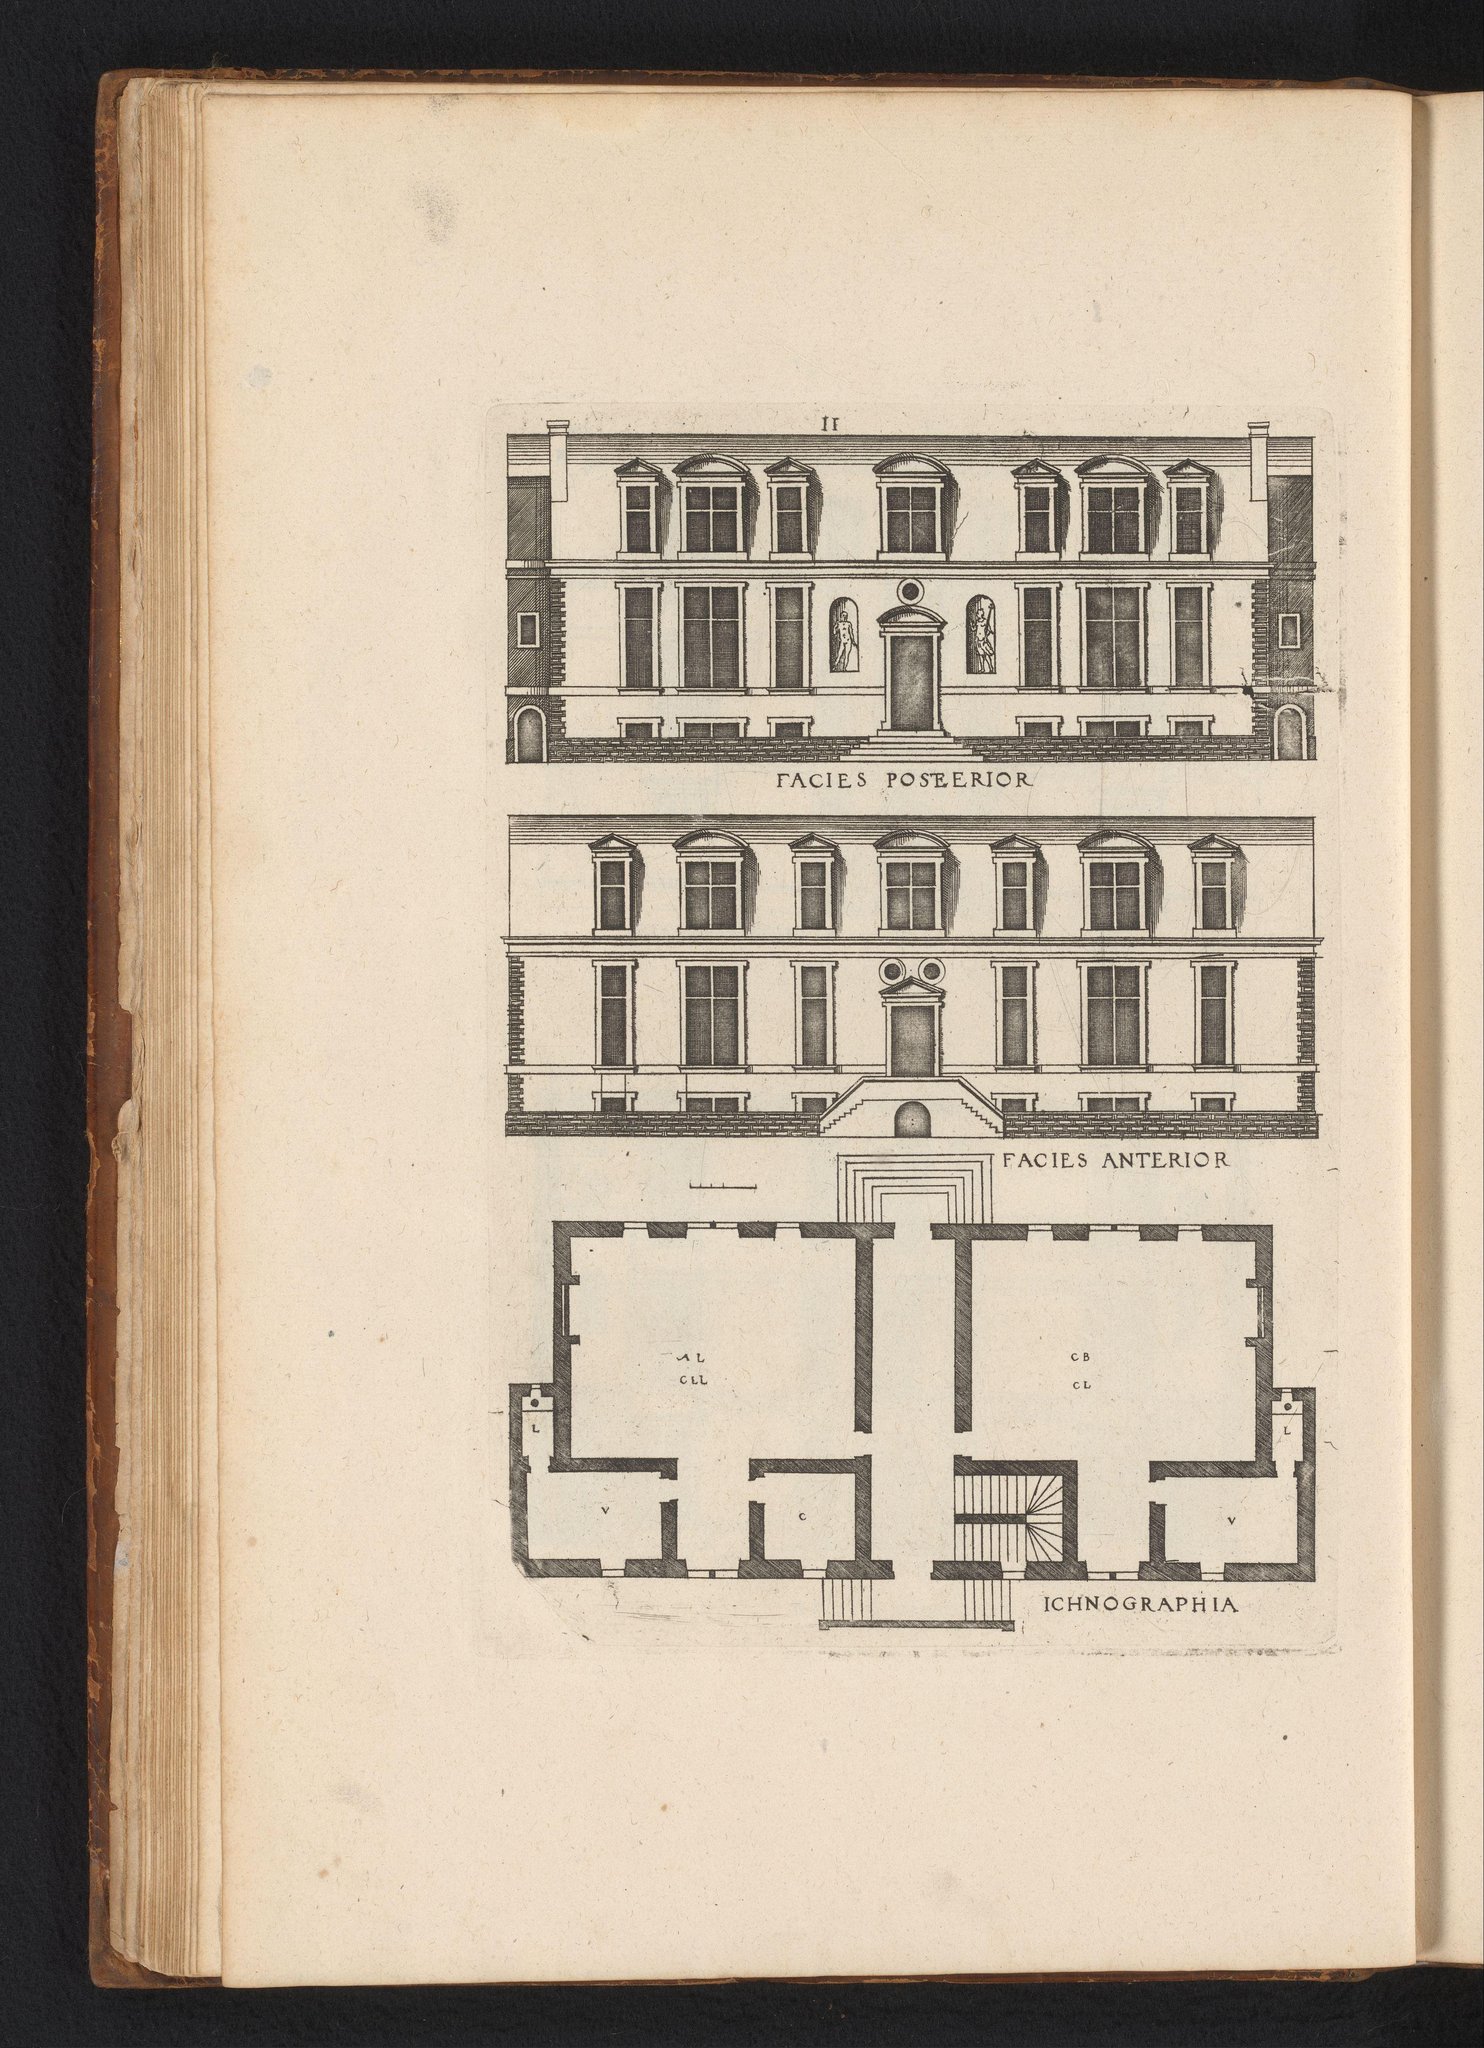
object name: ornament print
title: Voor- en achtergevel en plattegrond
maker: jacques androuet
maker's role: draughtsman, print maker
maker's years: 1515-1584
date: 1559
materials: paper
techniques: etching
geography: paris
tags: façade (of house or building), plan ~ architecture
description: Voor- en achtergevel en plattegrond. Aanzichten en plattegrond van architectuur. Genummerd: II. Onderdeel van 'De architectura Iacobi Androuetii du Cerceau' (1559): 69 etsen met 171 voorstellingen van architectuur en ornamentiek.